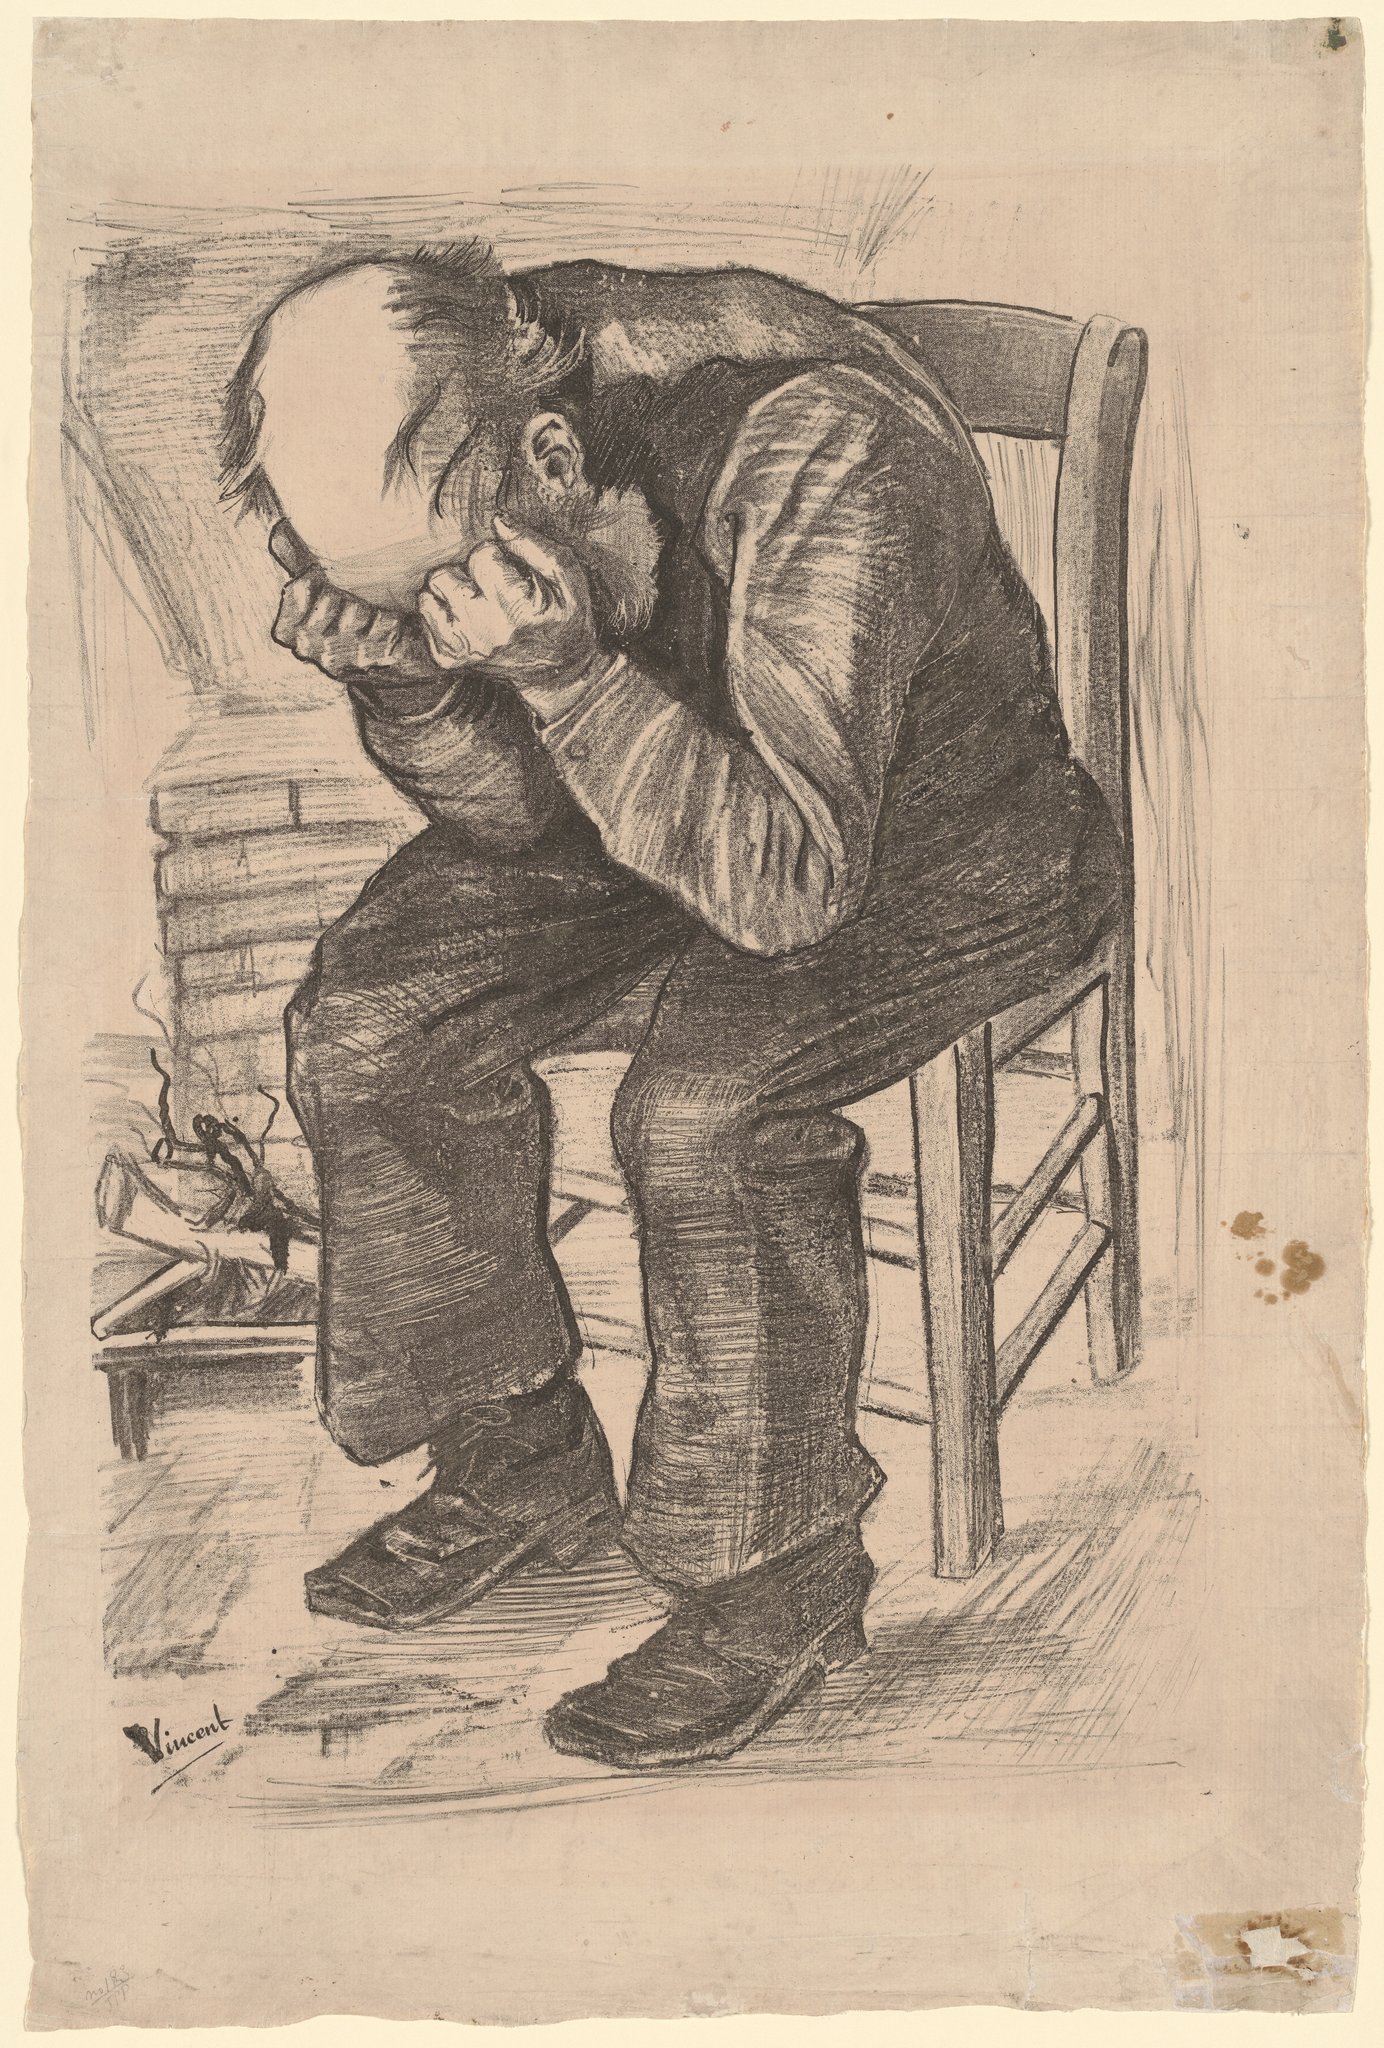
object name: print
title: At Eternity's Gate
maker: vincent van gogh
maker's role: artist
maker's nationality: dutch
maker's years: 1853-1890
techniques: lithography